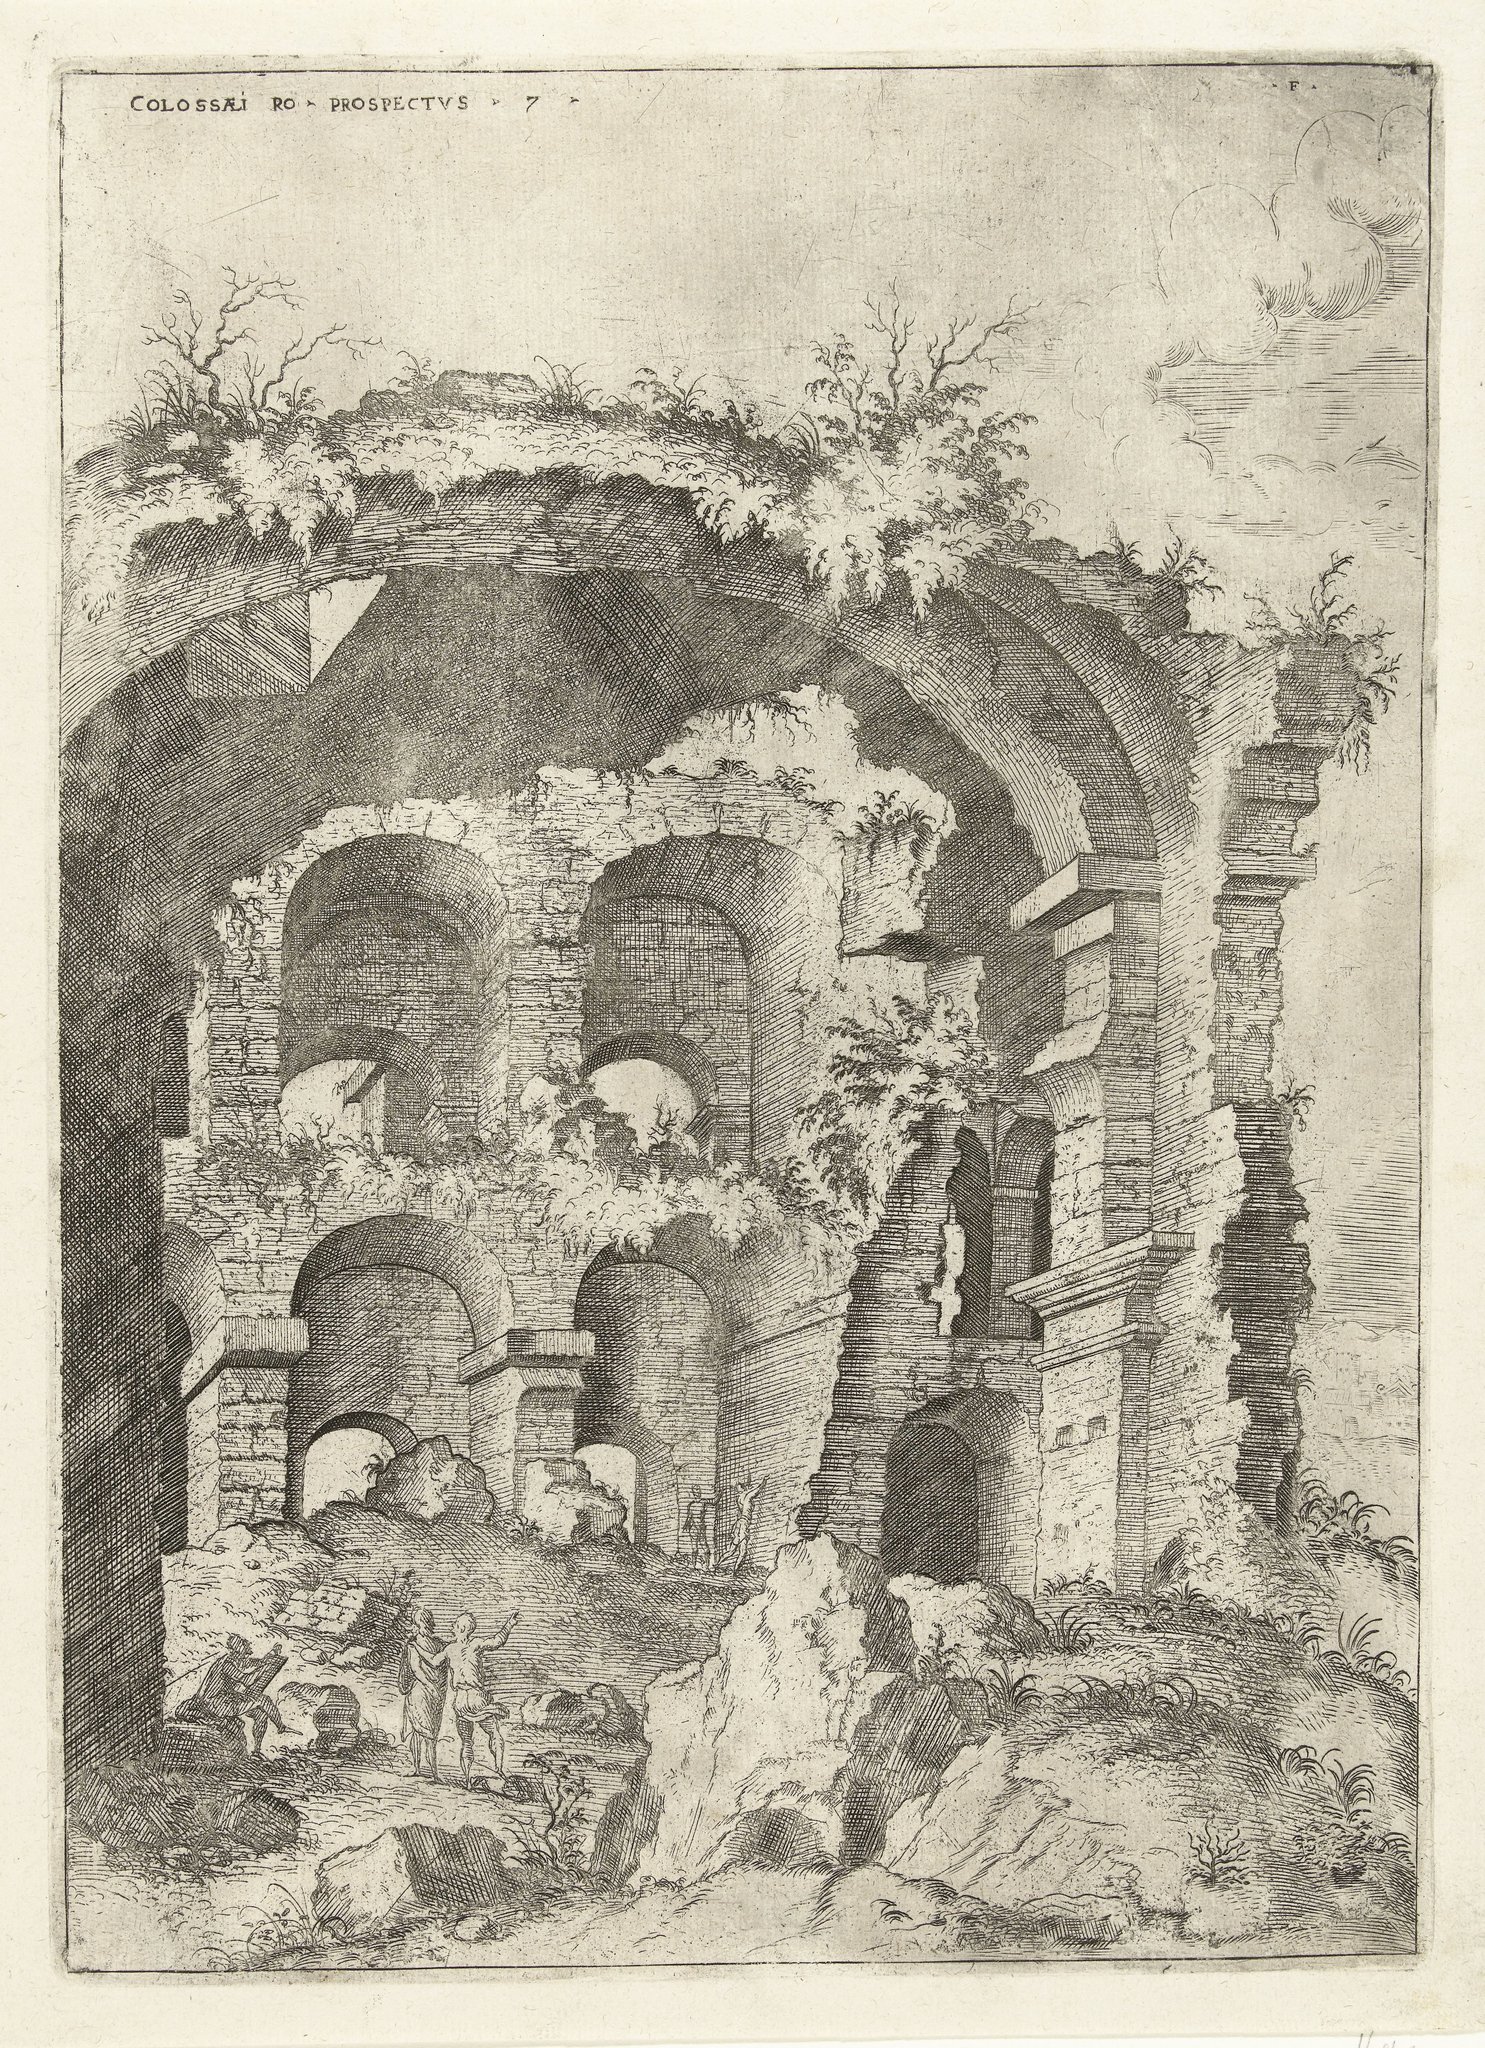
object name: print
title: Romeinse ruïnes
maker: hieronymus cock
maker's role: print maker, publisher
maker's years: 1518-1570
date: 1551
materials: paper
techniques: etching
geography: antwerp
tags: artist (in general) studying classical remains - bb - out of doors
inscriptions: collector's mark: Lugt 2228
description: Zevende gezicht op de ruïnes van het Colosseum te Rome. Links zit een kunstenaar te tekenen. Prent uit een serie van 25 prenten met Romeinse ruïnes.